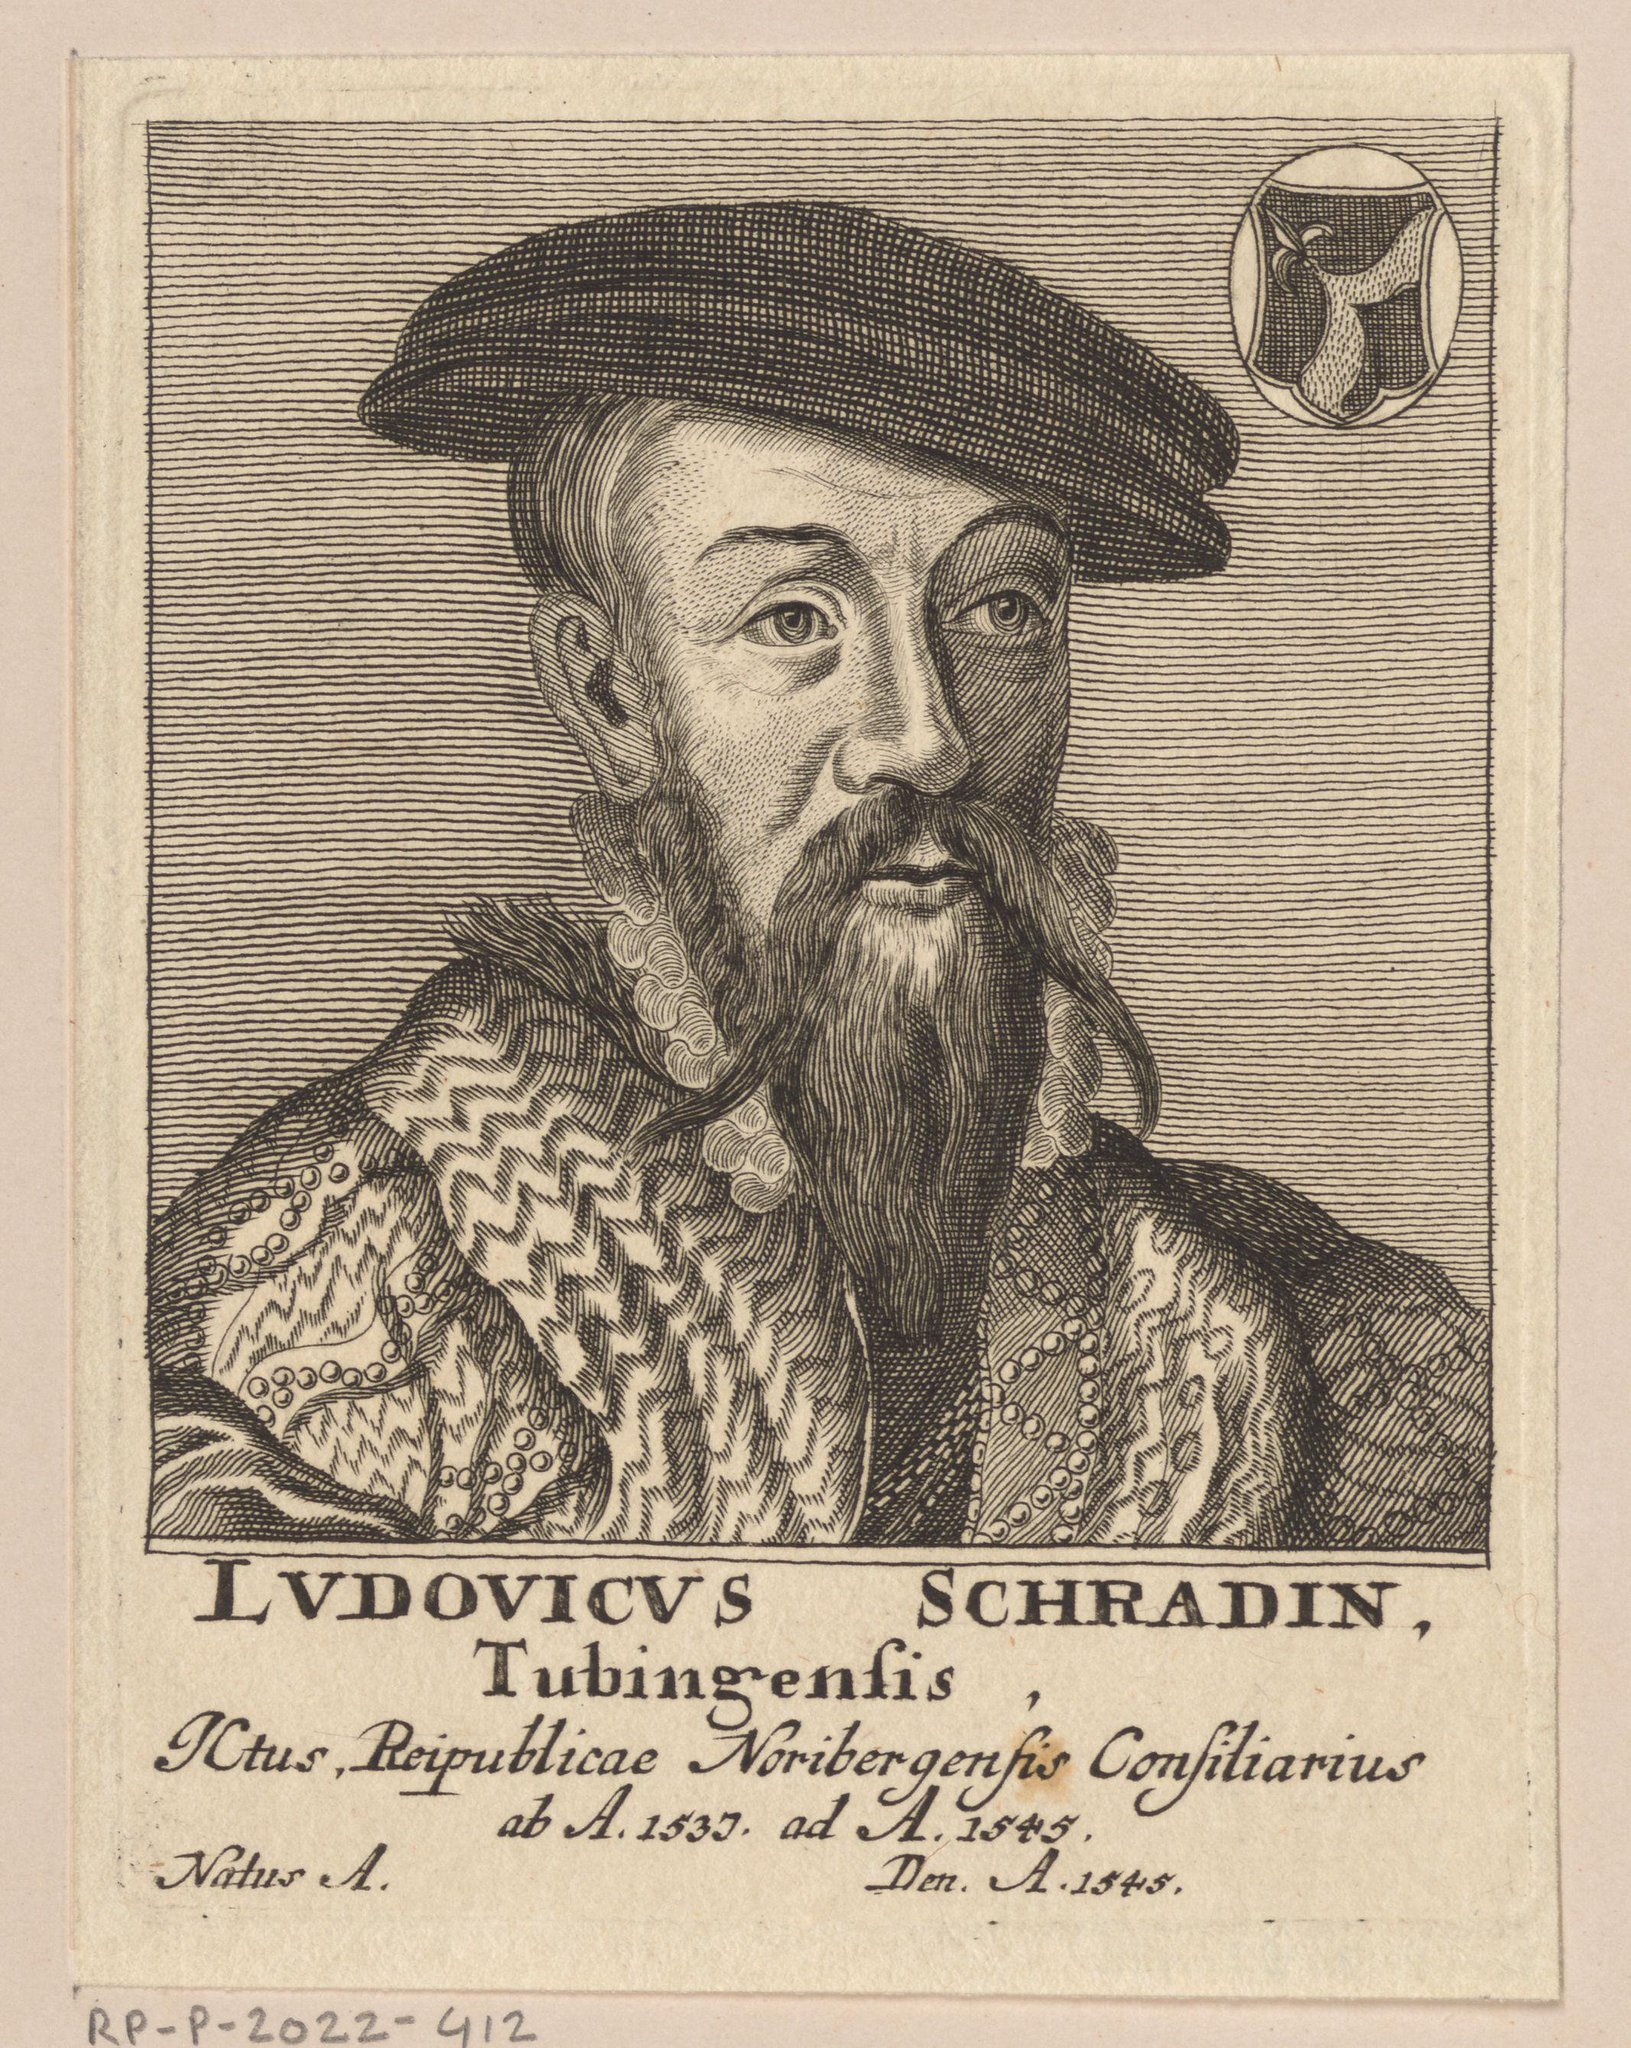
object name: print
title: Portret van Ludwig Schradin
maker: Anonymous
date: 1723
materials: paper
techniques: engraving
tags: historical persons, armorial bearing, heraldry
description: Prent mogelijk uit: Rothscholtz, Friedrich. Icones consiliariorum de illustri republica Noribergensi (...). Neurenberg en Altdorf: erven Johann Daniel Tauber, 1723.